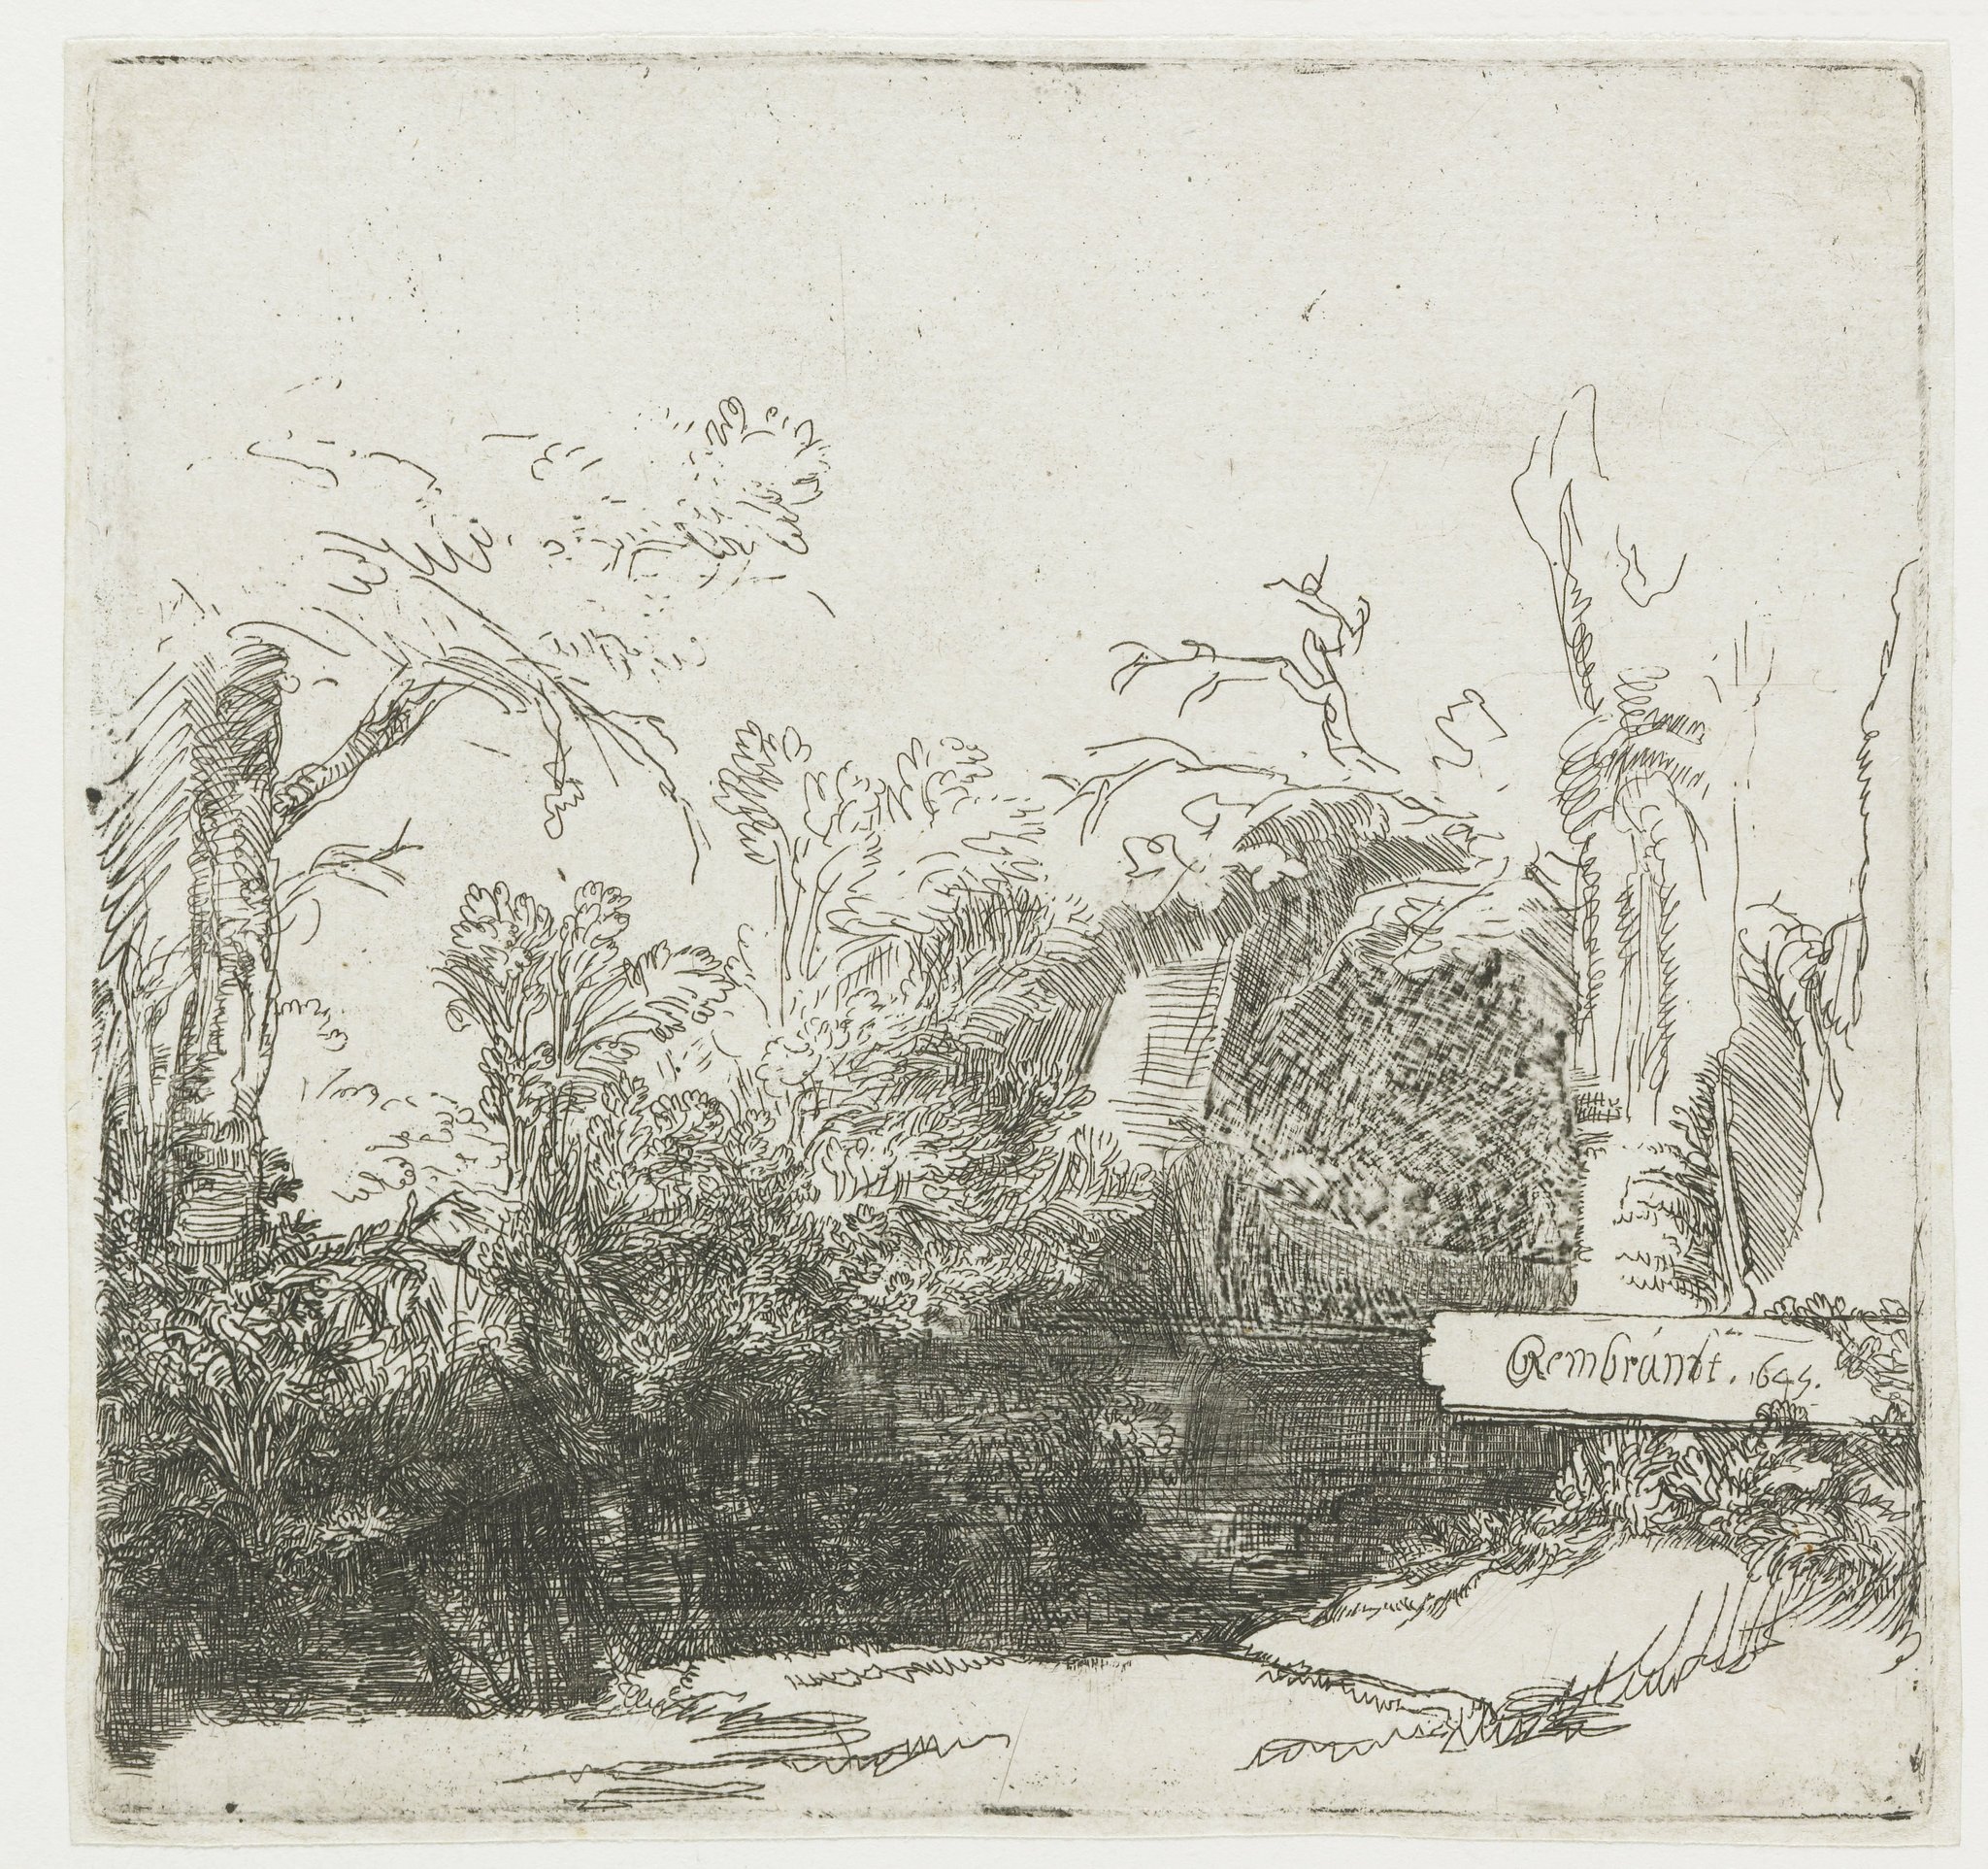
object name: print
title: A brook with a grotto and a boat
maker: rembrandt van rijn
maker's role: draughtsman, painter, print maker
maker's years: 1606-1669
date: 1645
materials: paper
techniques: drypoint, etching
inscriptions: signature and date: ‘Rembrandt . 1645’, collector's mark: Lugt 240